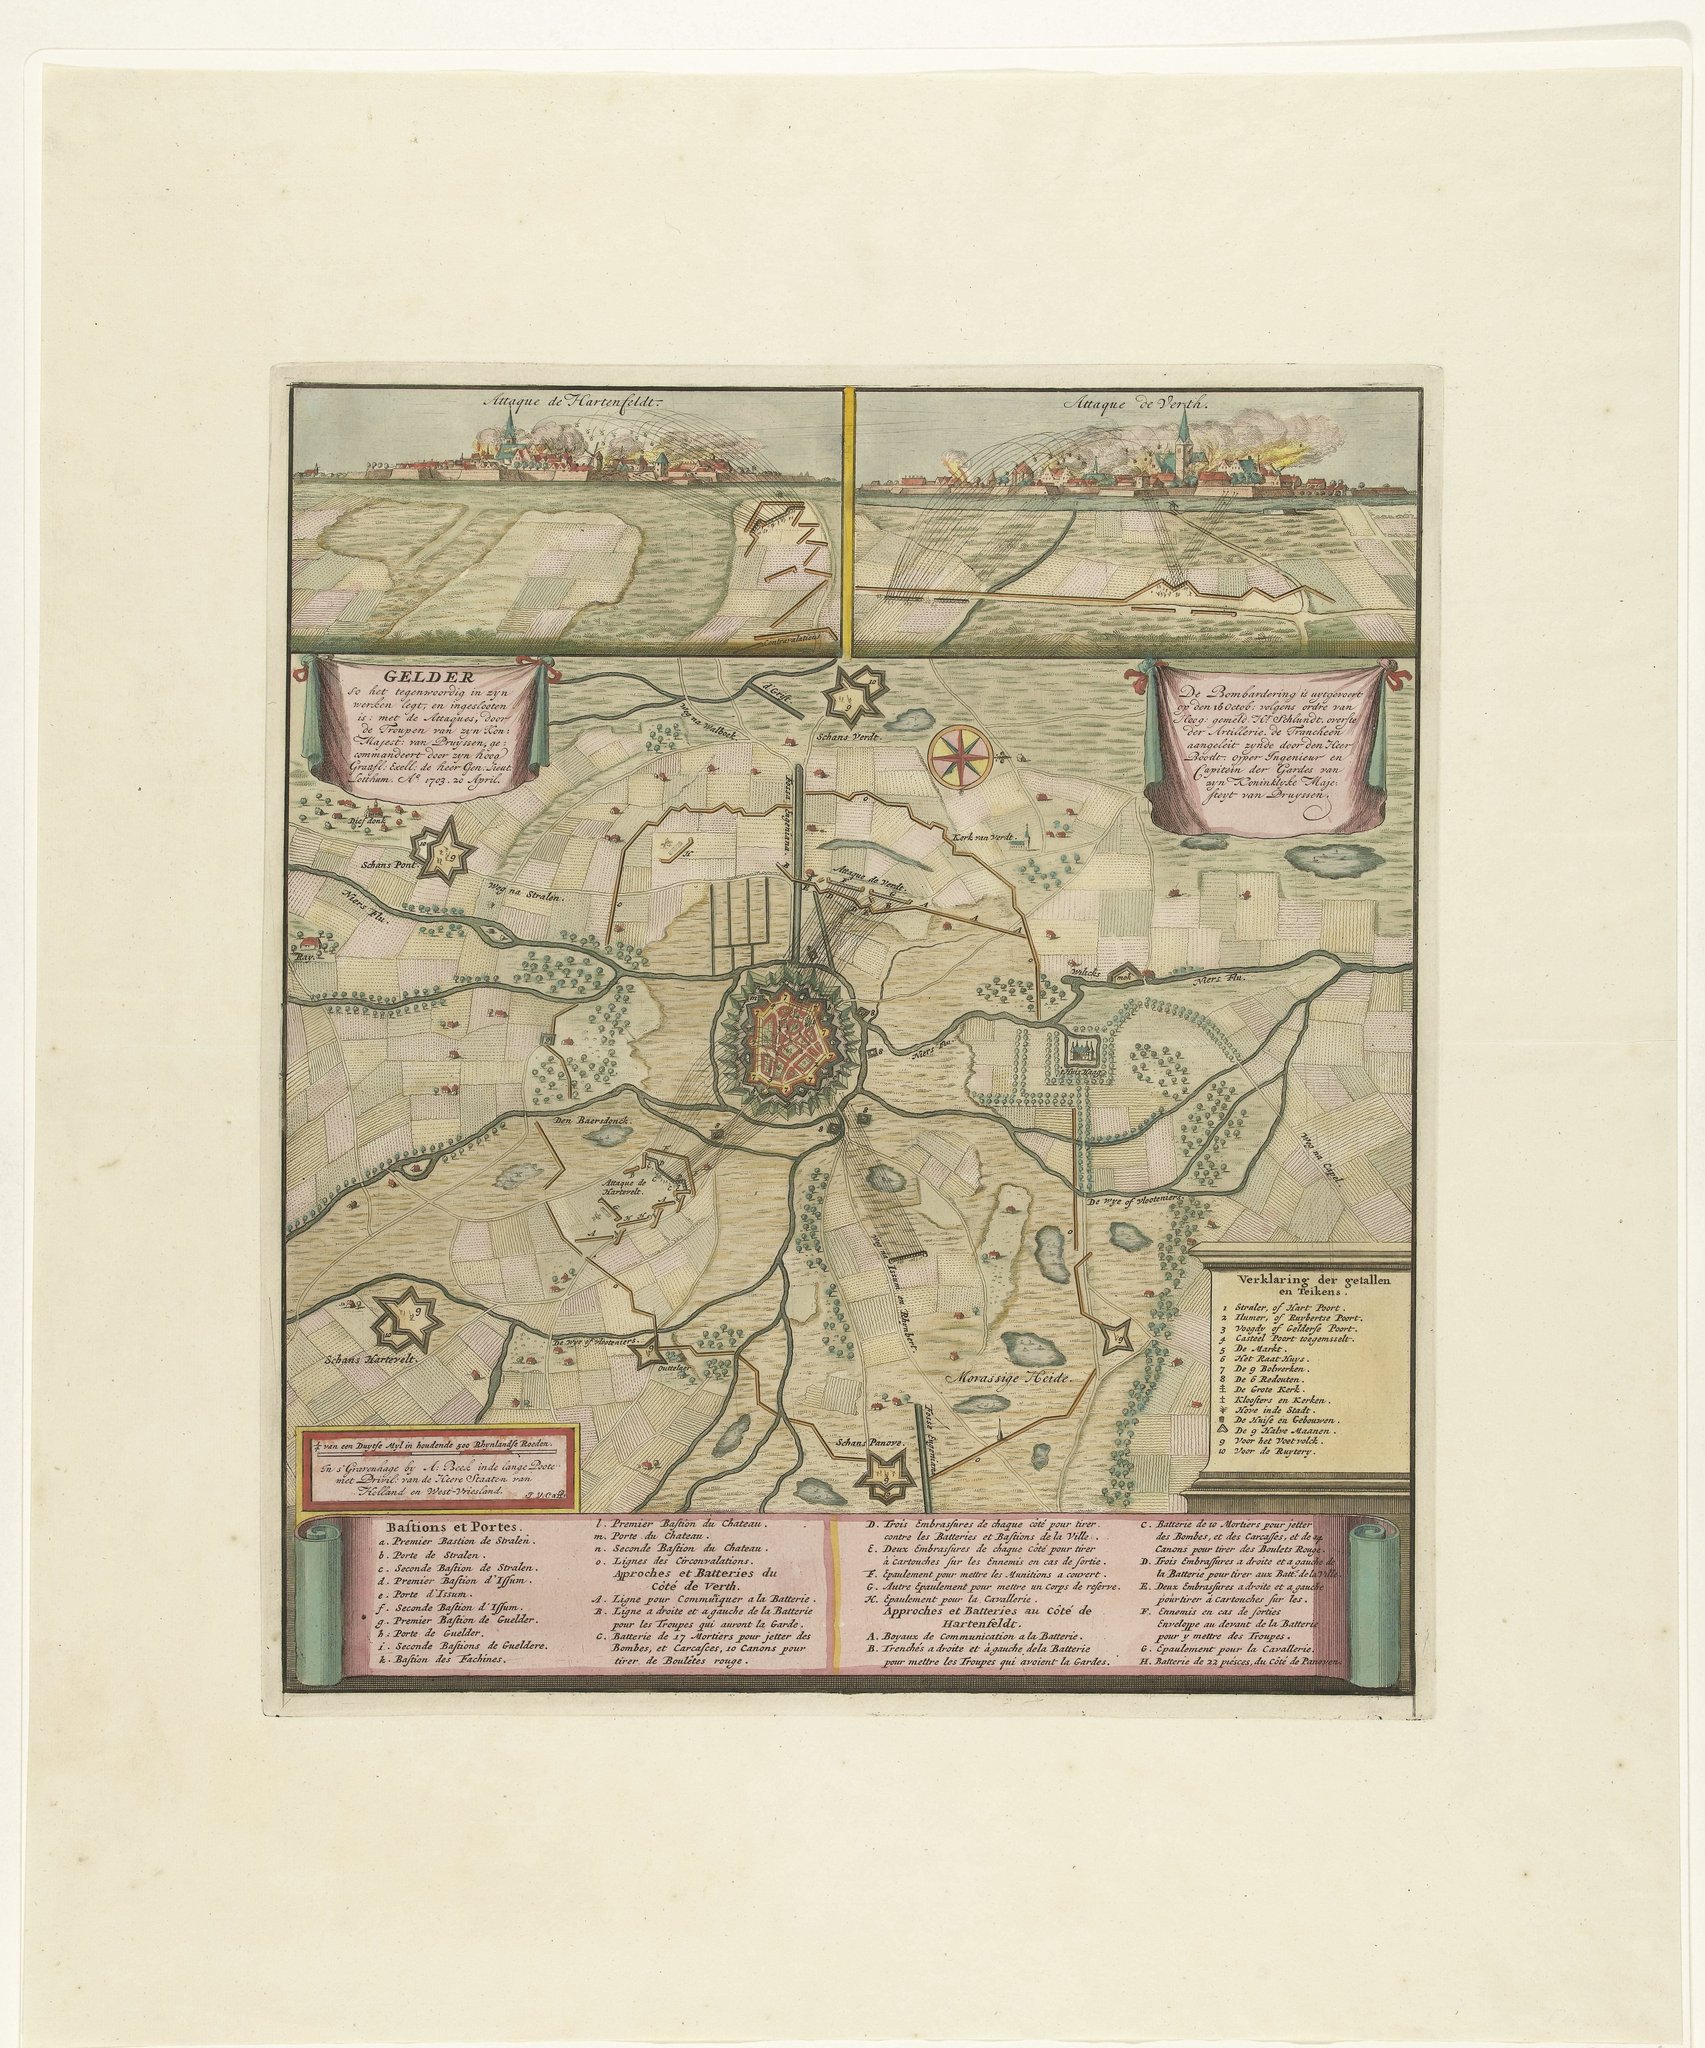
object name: map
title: Gelder so het tegenwoordig in zyn werken legt, en ingeslooten is: met de attaques, door de troupen van zyn kon. majest. van Pruyssen, gecommandeert door zyn hoog. graafl. excell. de heer gen. lieut. Lotthum. ao. 1703. 20 april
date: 1703-1717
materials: paper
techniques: engraving, etching, hand coloring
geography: northern netherlands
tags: siege, position war, maps of cities, bombardment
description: Kaart van Geldern en omgeving, tijdens het beleg door de Pruisische troepen onder generaal Lotthum op 20 april. Bovenaan het bombardement van de stad op 7 oktober 1703 gezien vanuit Hartenfeldt en Verth. Onderaan de verklaringen in het Frans.